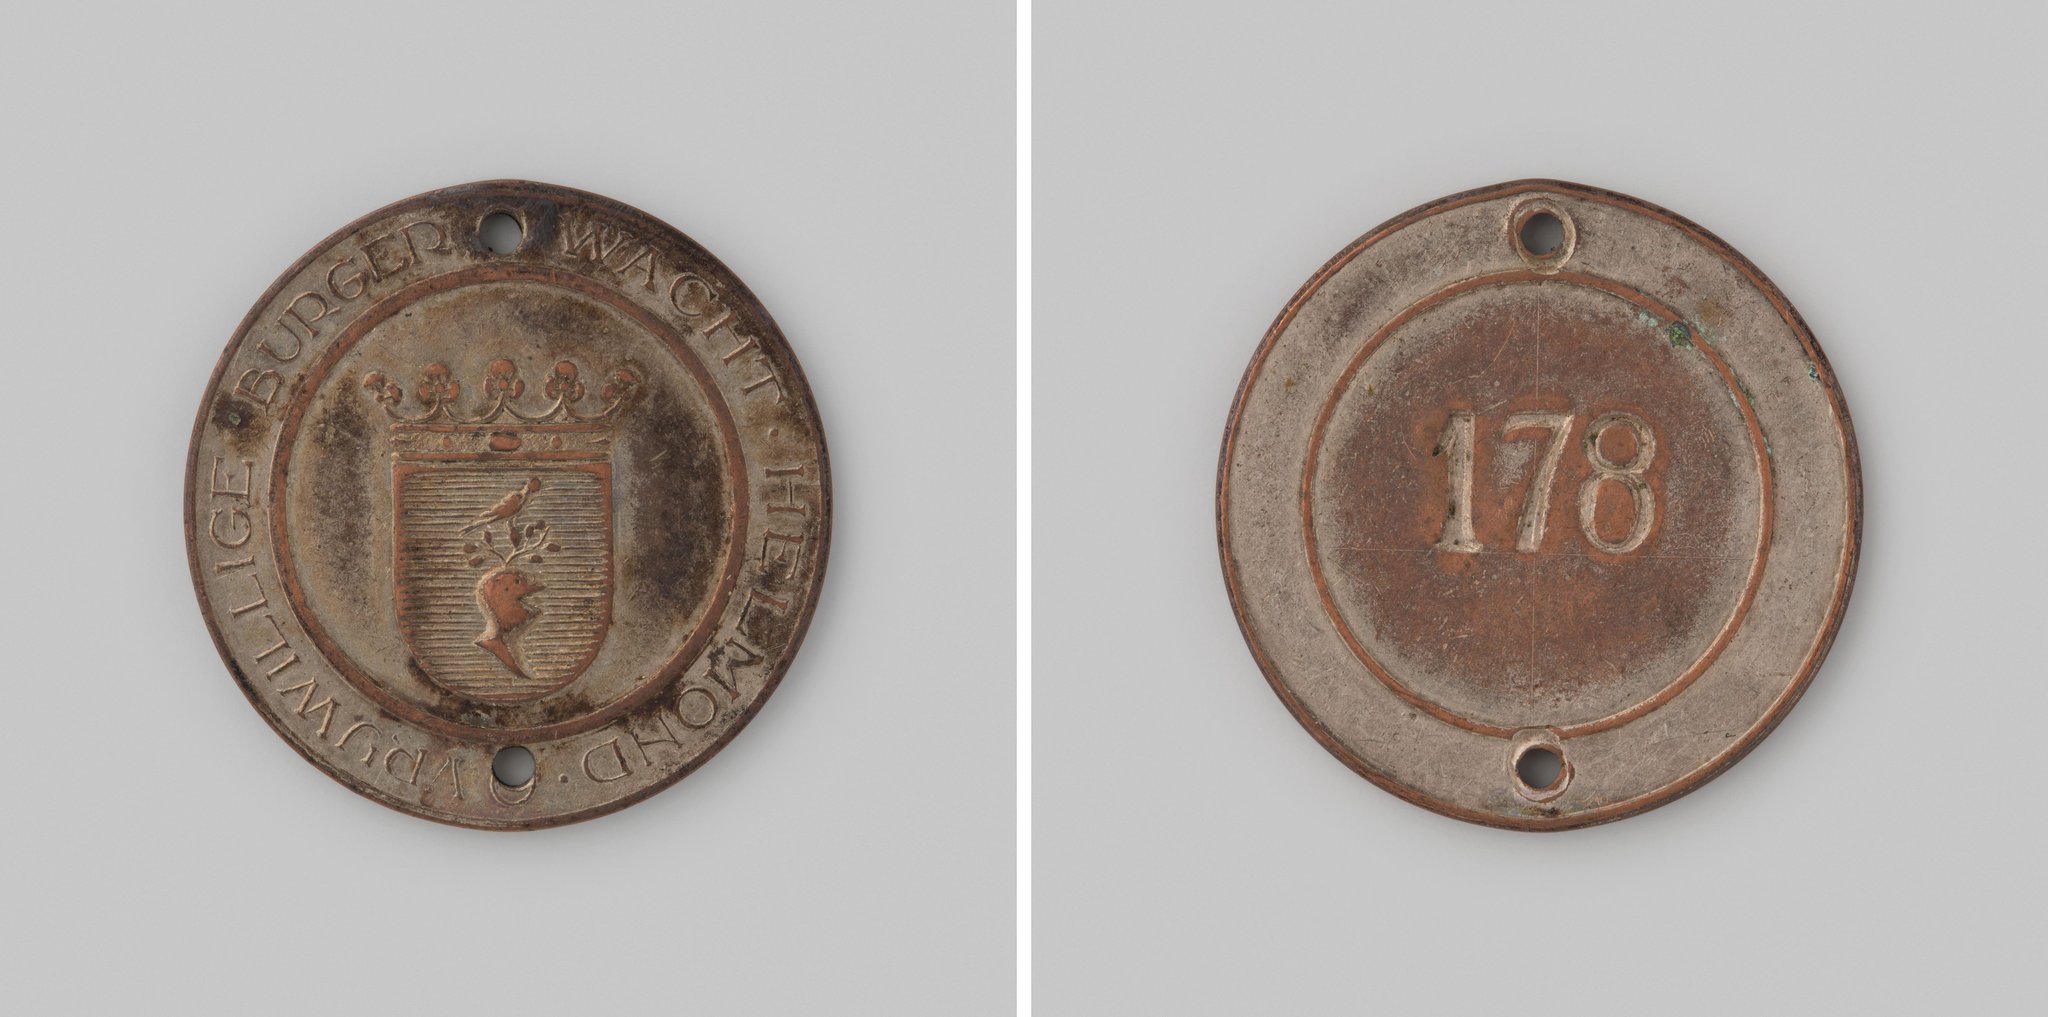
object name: presentiepenning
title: Presentiepenning Vrijwillige Burgerwacht Helmond, met nummer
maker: Anonymous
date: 1918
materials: metal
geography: helmond